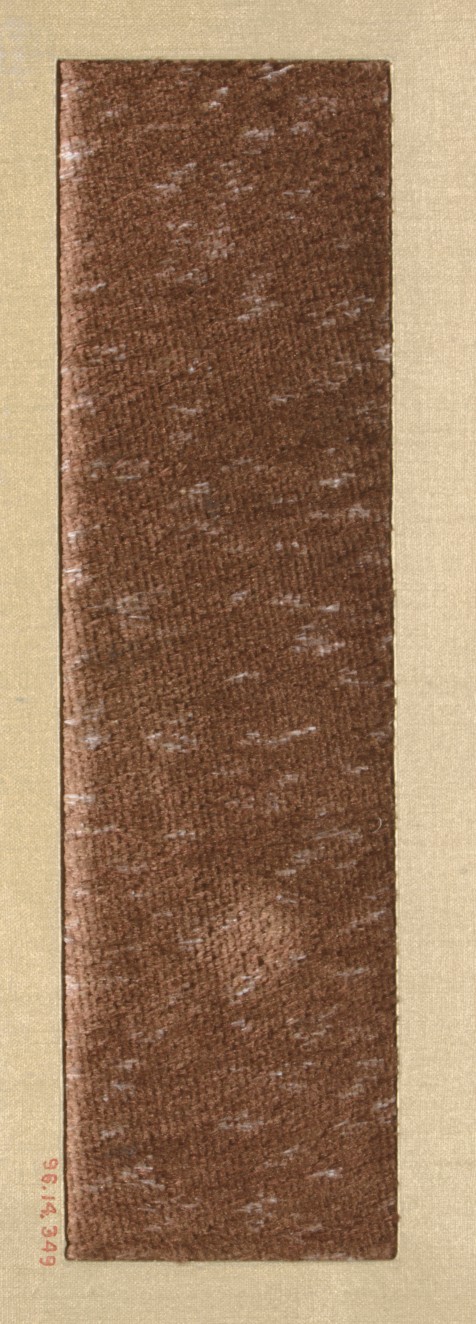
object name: piece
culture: japanese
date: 1701-1900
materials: silk